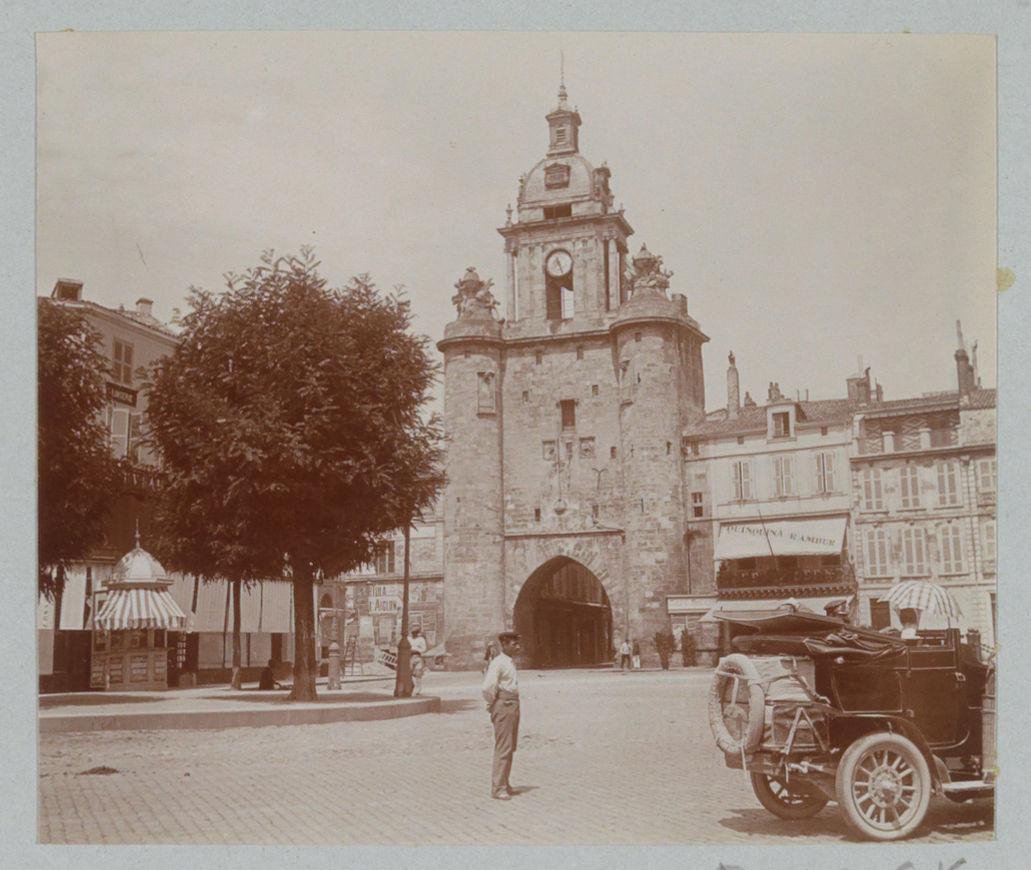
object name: photograph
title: Klokkentoren van La Rochelle met op de voorgrond een man en een auto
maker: Anonymous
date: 1905-1910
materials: paper, photographic support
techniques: gelatin silver print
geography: la rochelle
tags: tower, clock tower ~ monumental adornment, automobile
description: Onderdeel van Fotoalbum van een Franse amateurfotograaf met bezienswaardigheden in Frankrijk, Zwitserland en Italië.